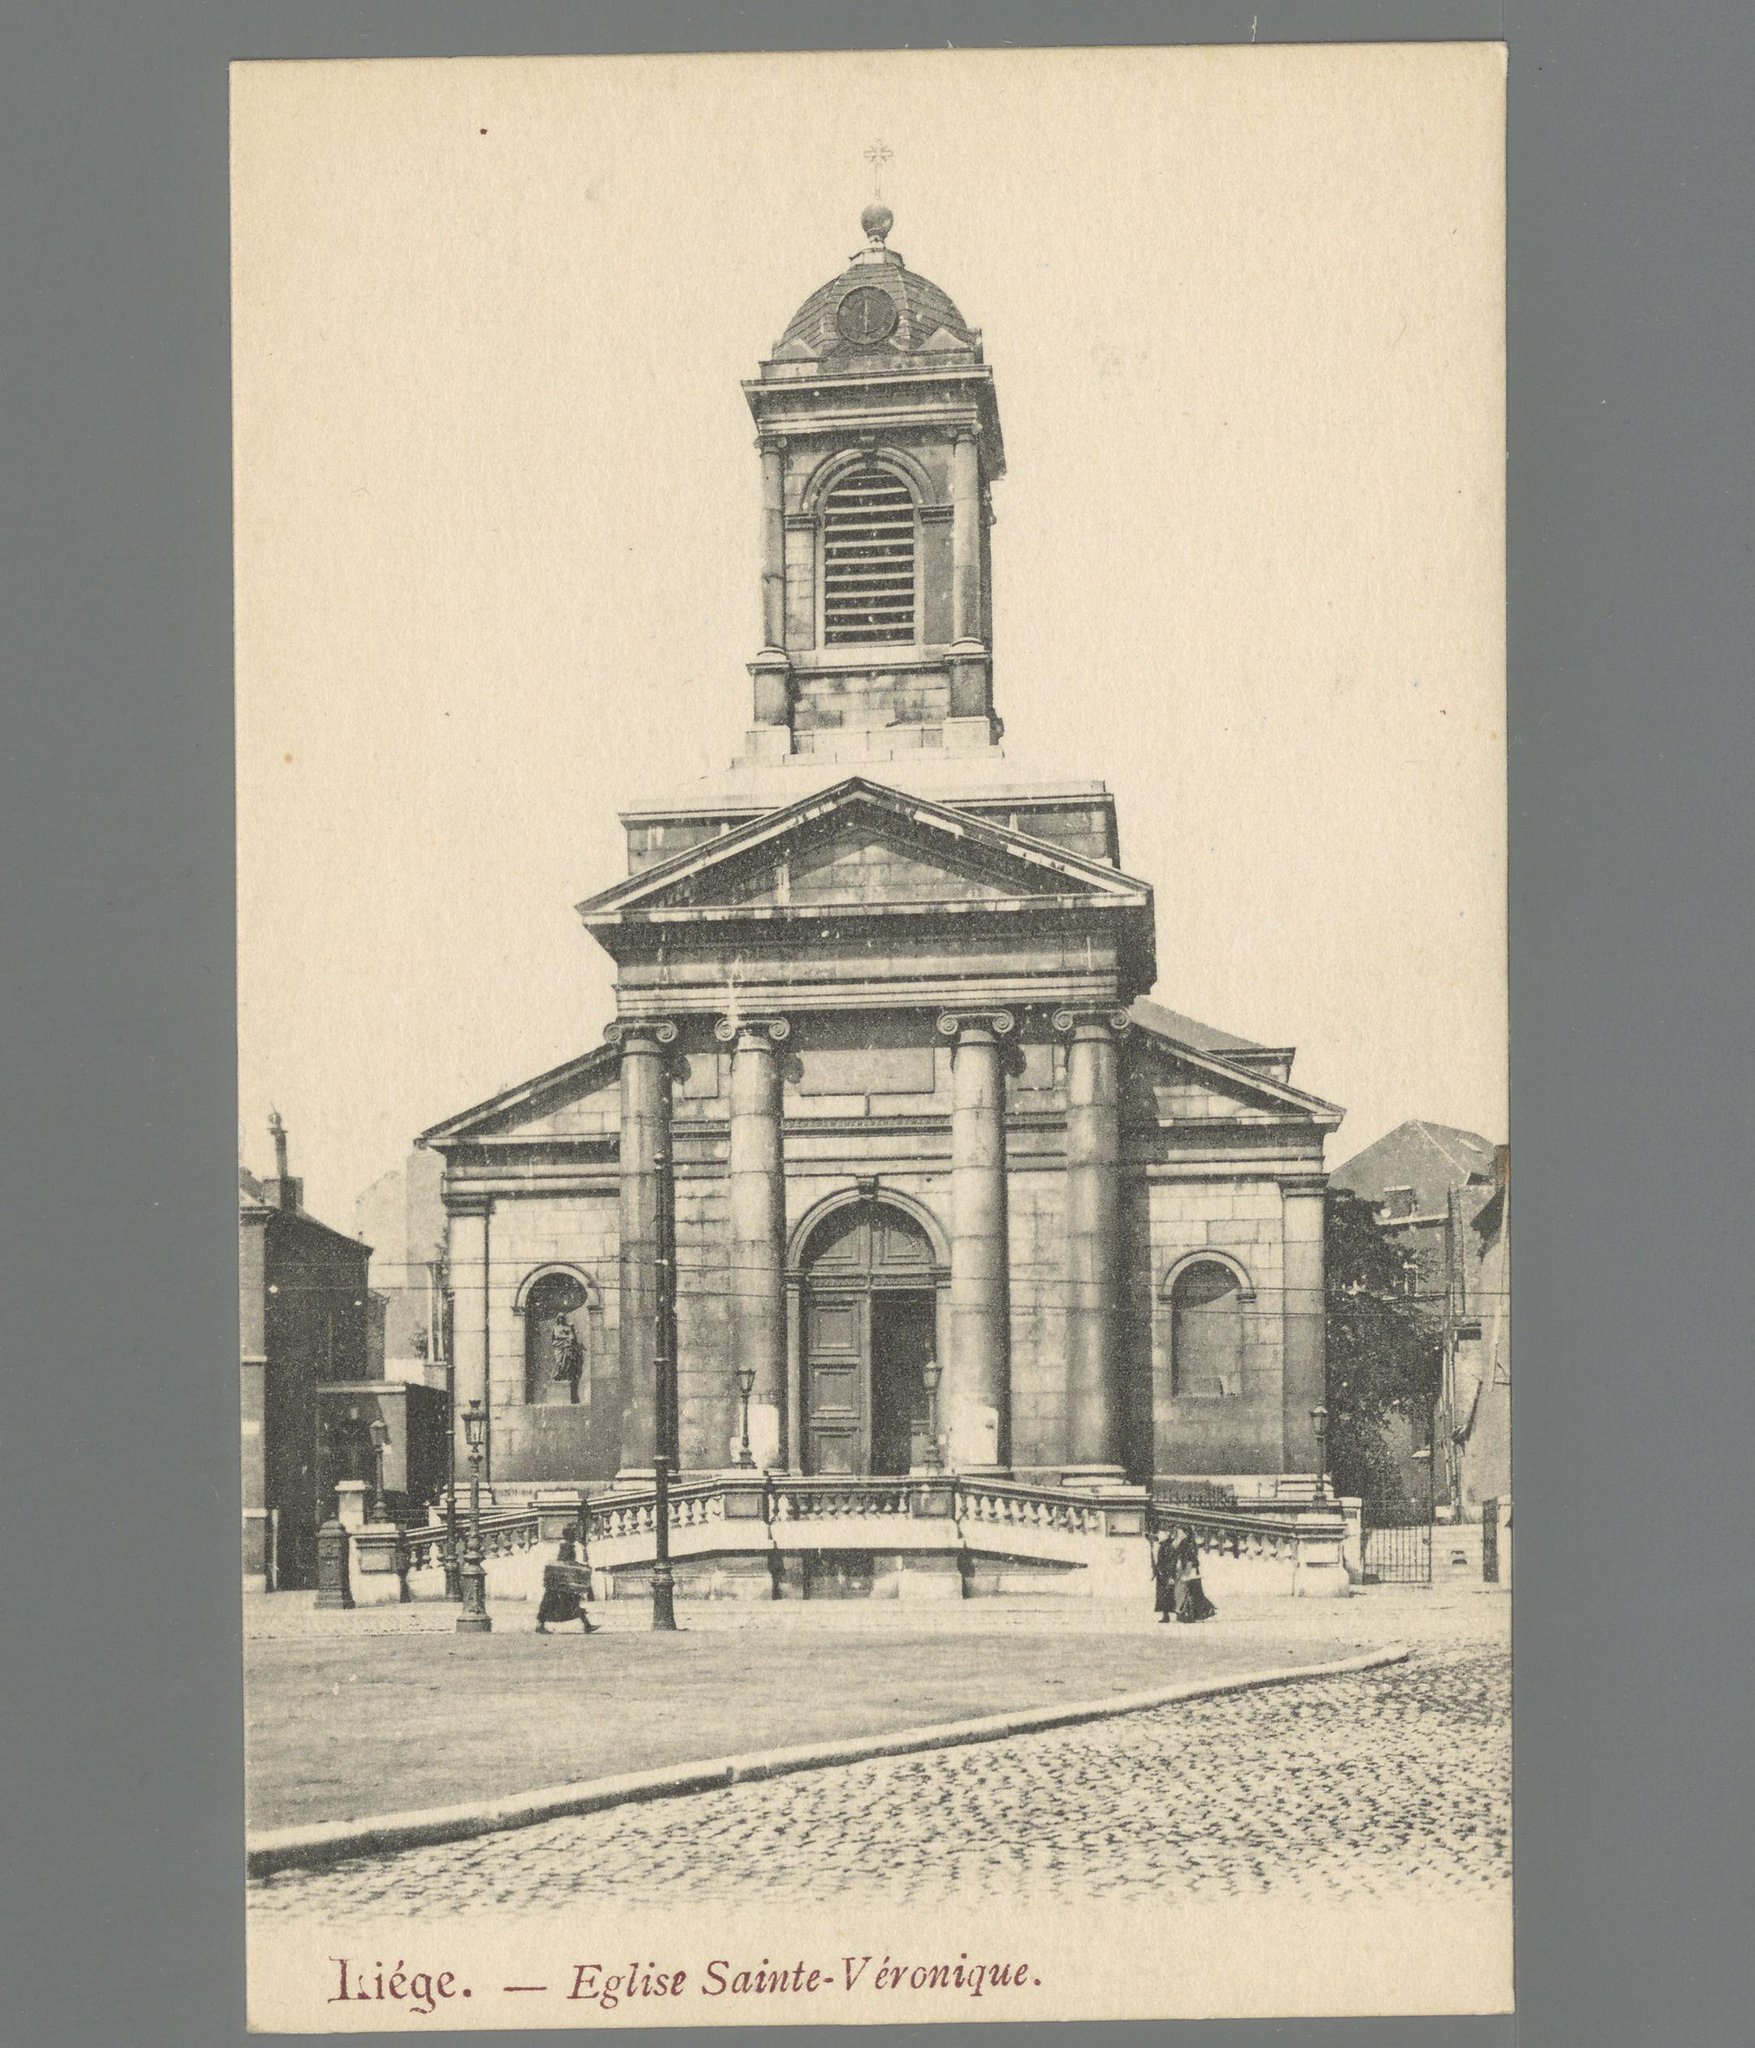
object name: ansichtkaart, prentbriefkaart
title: Liège. Eglise Sainte-Véronique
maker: Anonymous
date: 1897-1906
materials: cardboard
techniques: photograph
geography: liège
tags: square, place, circus, etc., church (exterior), liège